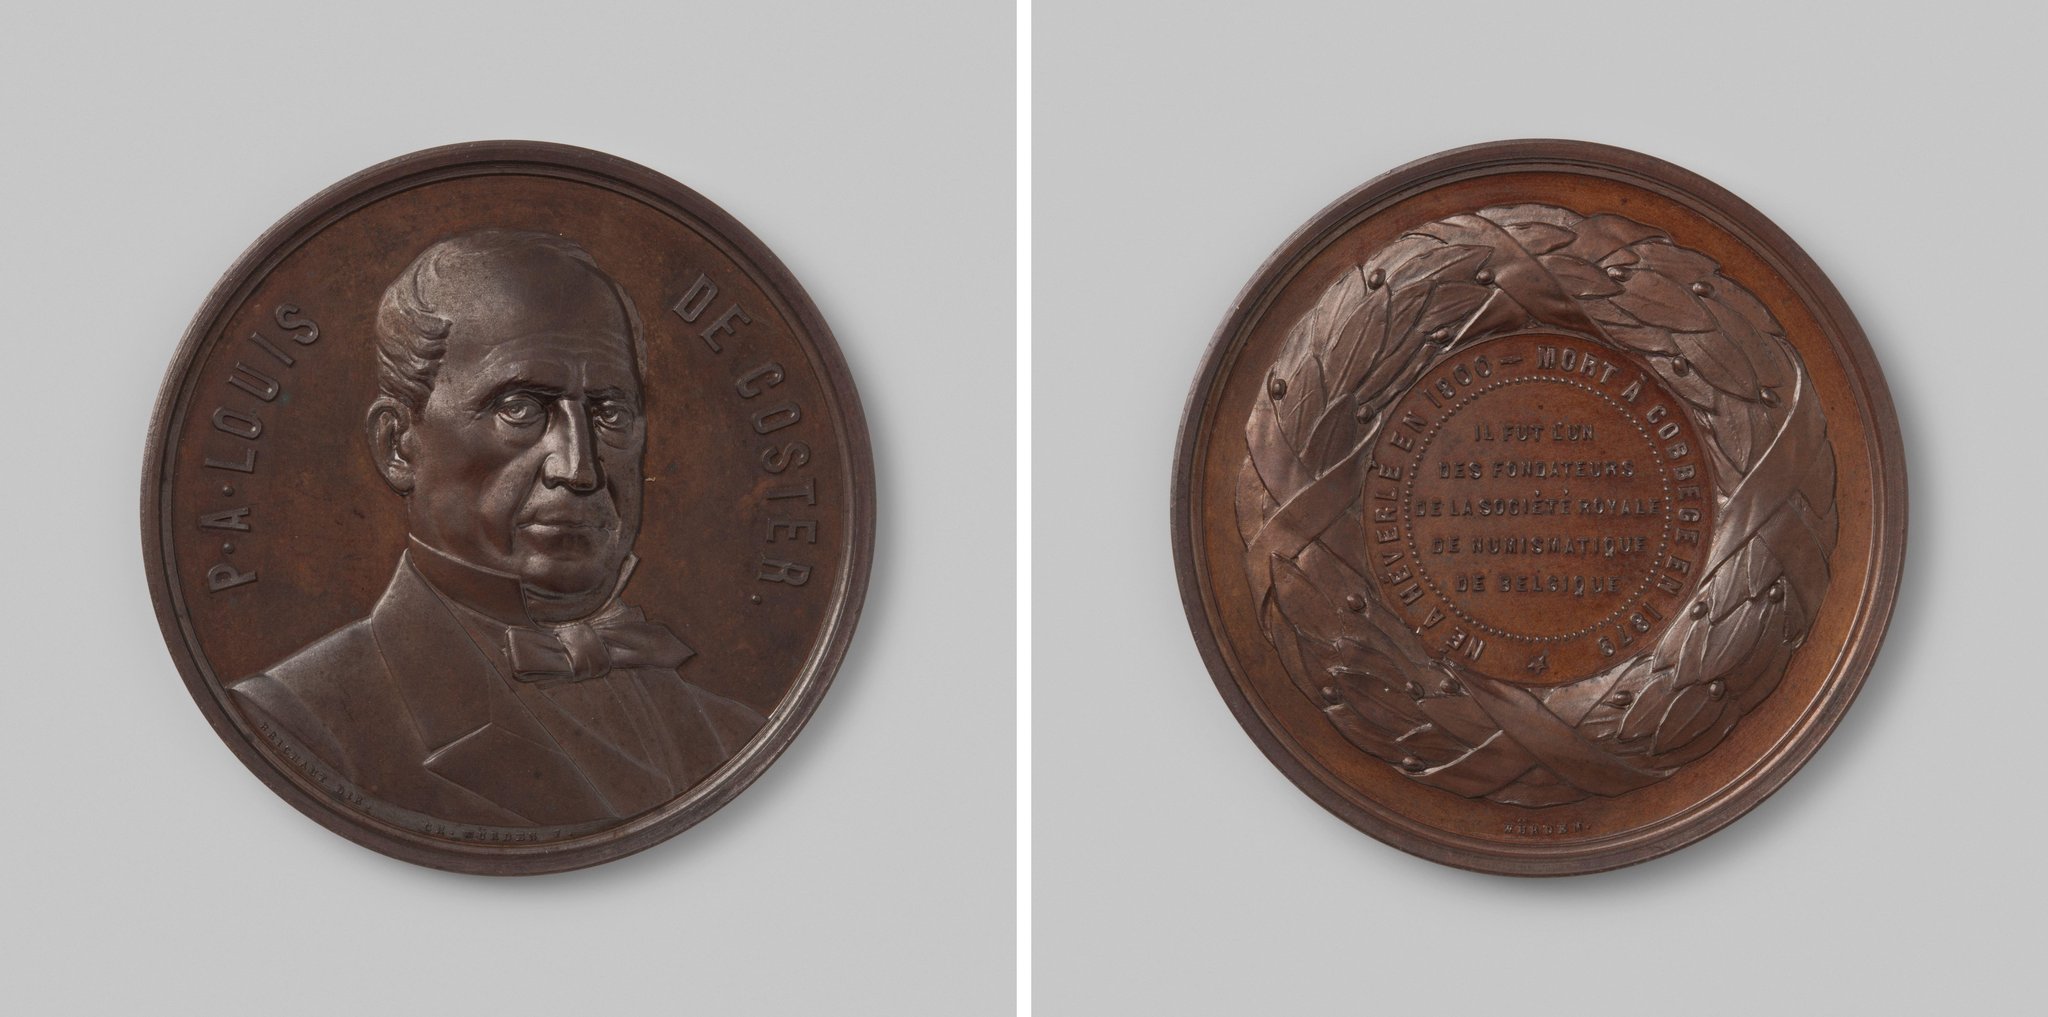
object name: history medal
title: Overlijden van P.A. Louis de Coster, medeoprichter van de Societe Royale de Numismatique de Belgique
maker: henri charles wurden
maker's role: medailleur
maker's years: 1847-1908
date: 1879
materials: bronze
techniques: striking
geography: brussels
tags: p.a. louis de coster, société royale de numismatique de belgique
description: Overlijden van P.A. Louis de Coster, medeoprichter van de Societe Royale de Numismatique de Belgique. Bronzen penning. Voorzijde: borststuk man binnen omschrift. Keerzijde: opschrift binnen omschrift en lauwerkrans